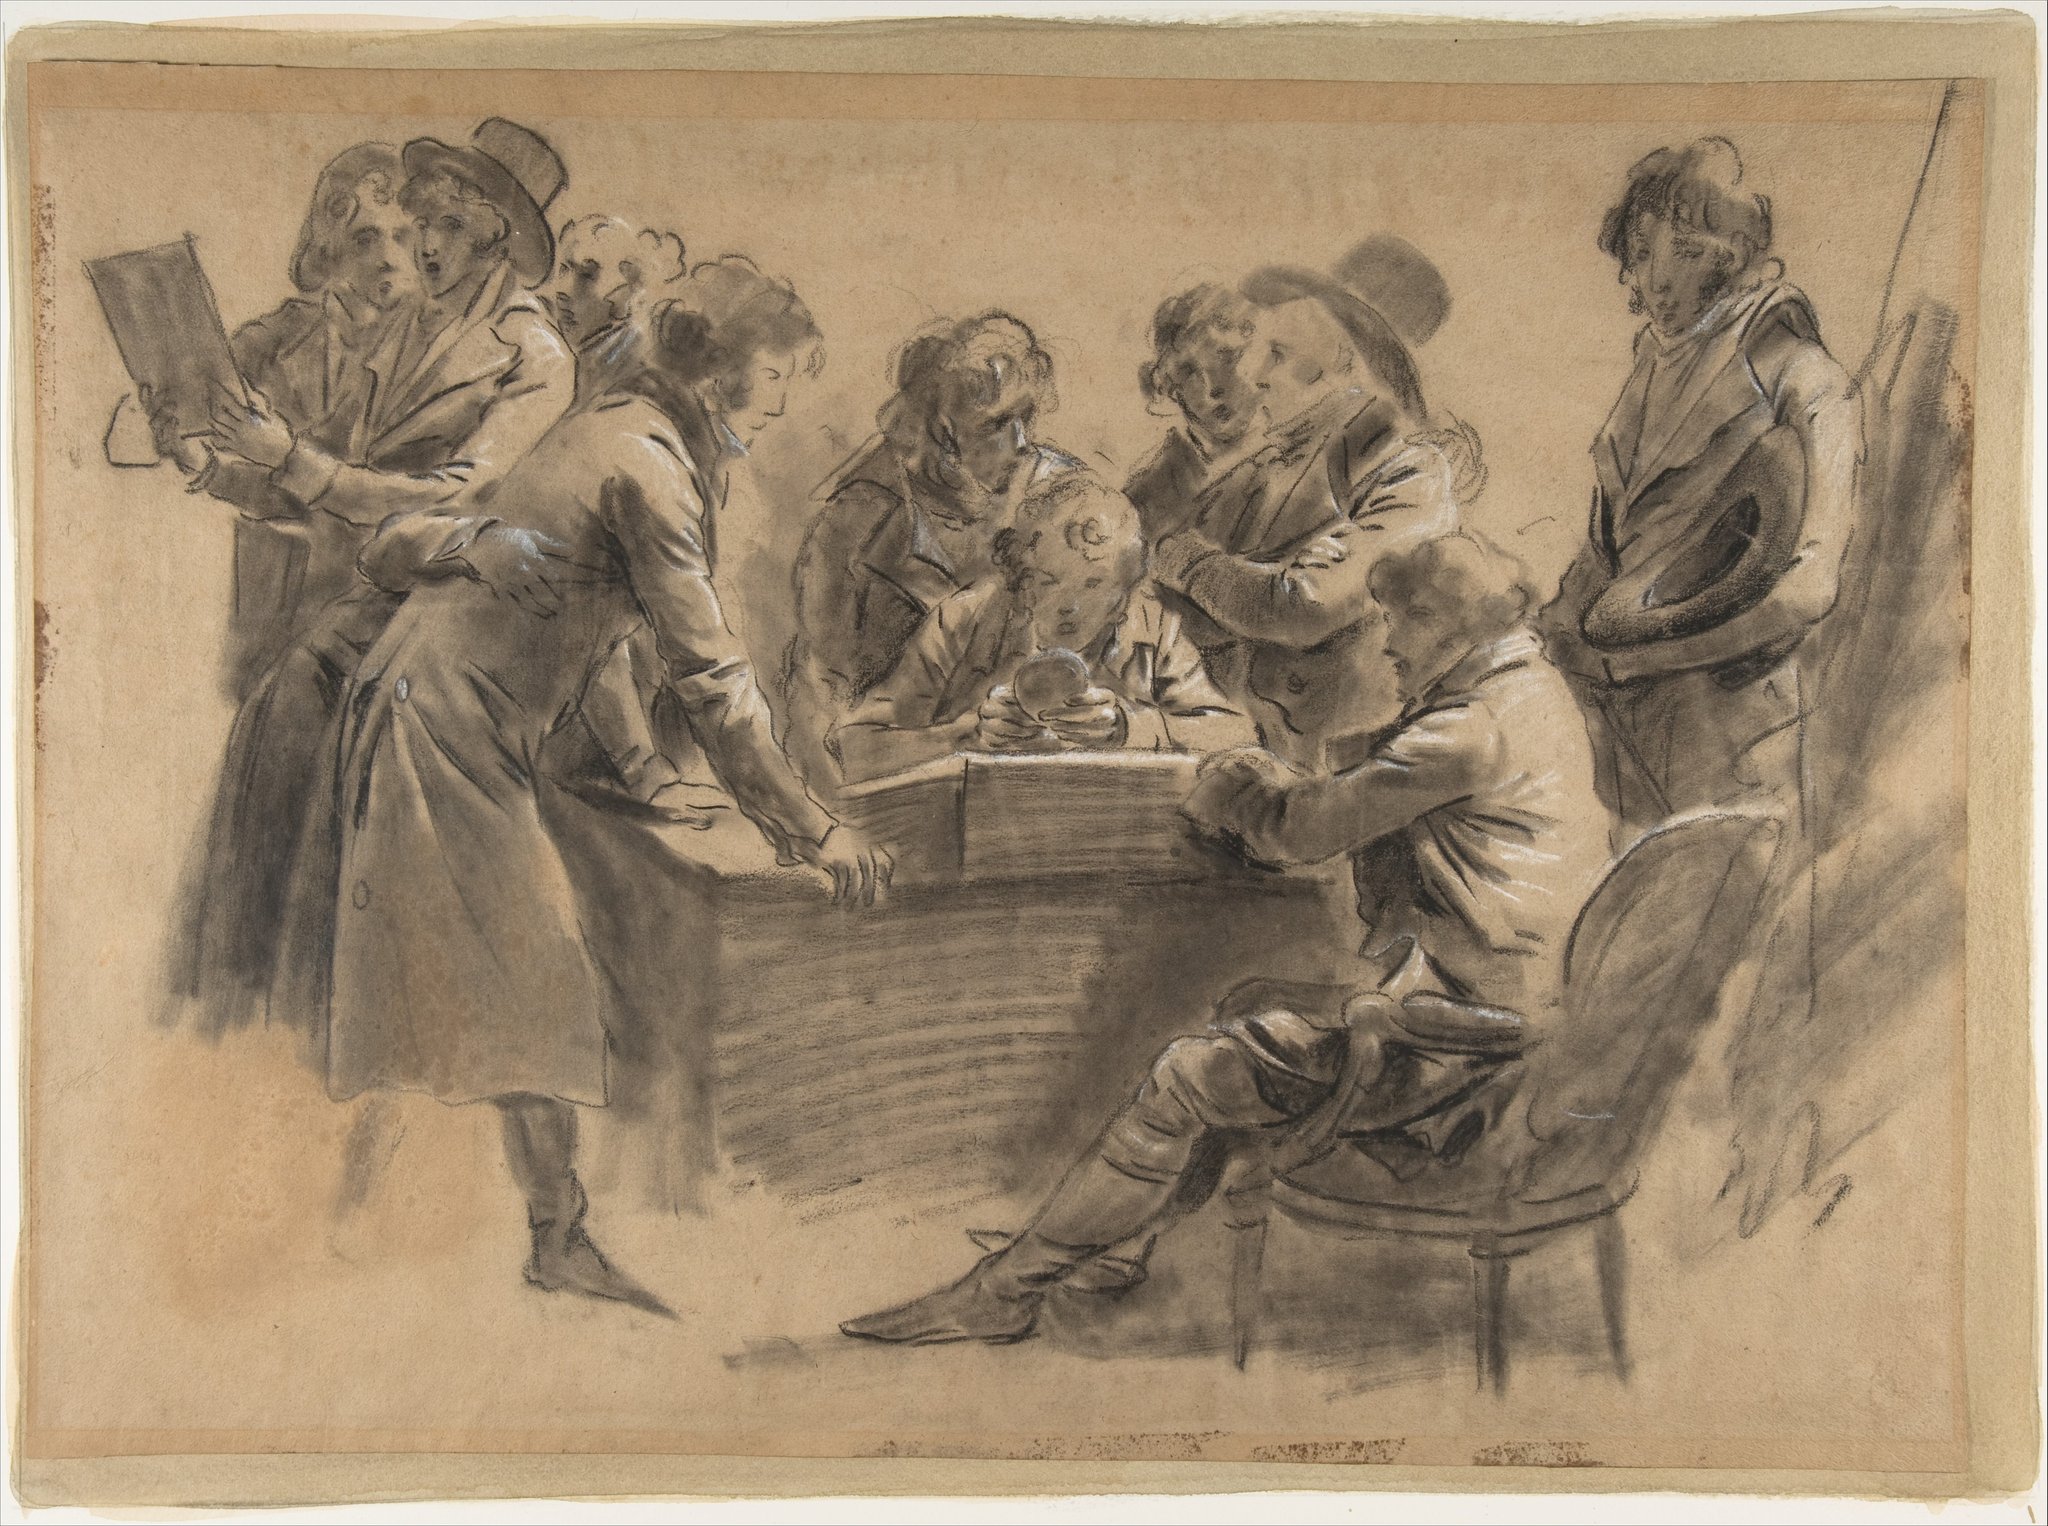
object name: drawing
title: Group of Artists in Jean-Baptiste Isabey's Studio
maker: louis léopold boilly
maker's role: artist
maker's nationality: french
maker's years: 1761-1845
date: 1798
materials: chalk, crayon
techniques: heightening, stumping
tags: men,women,artists